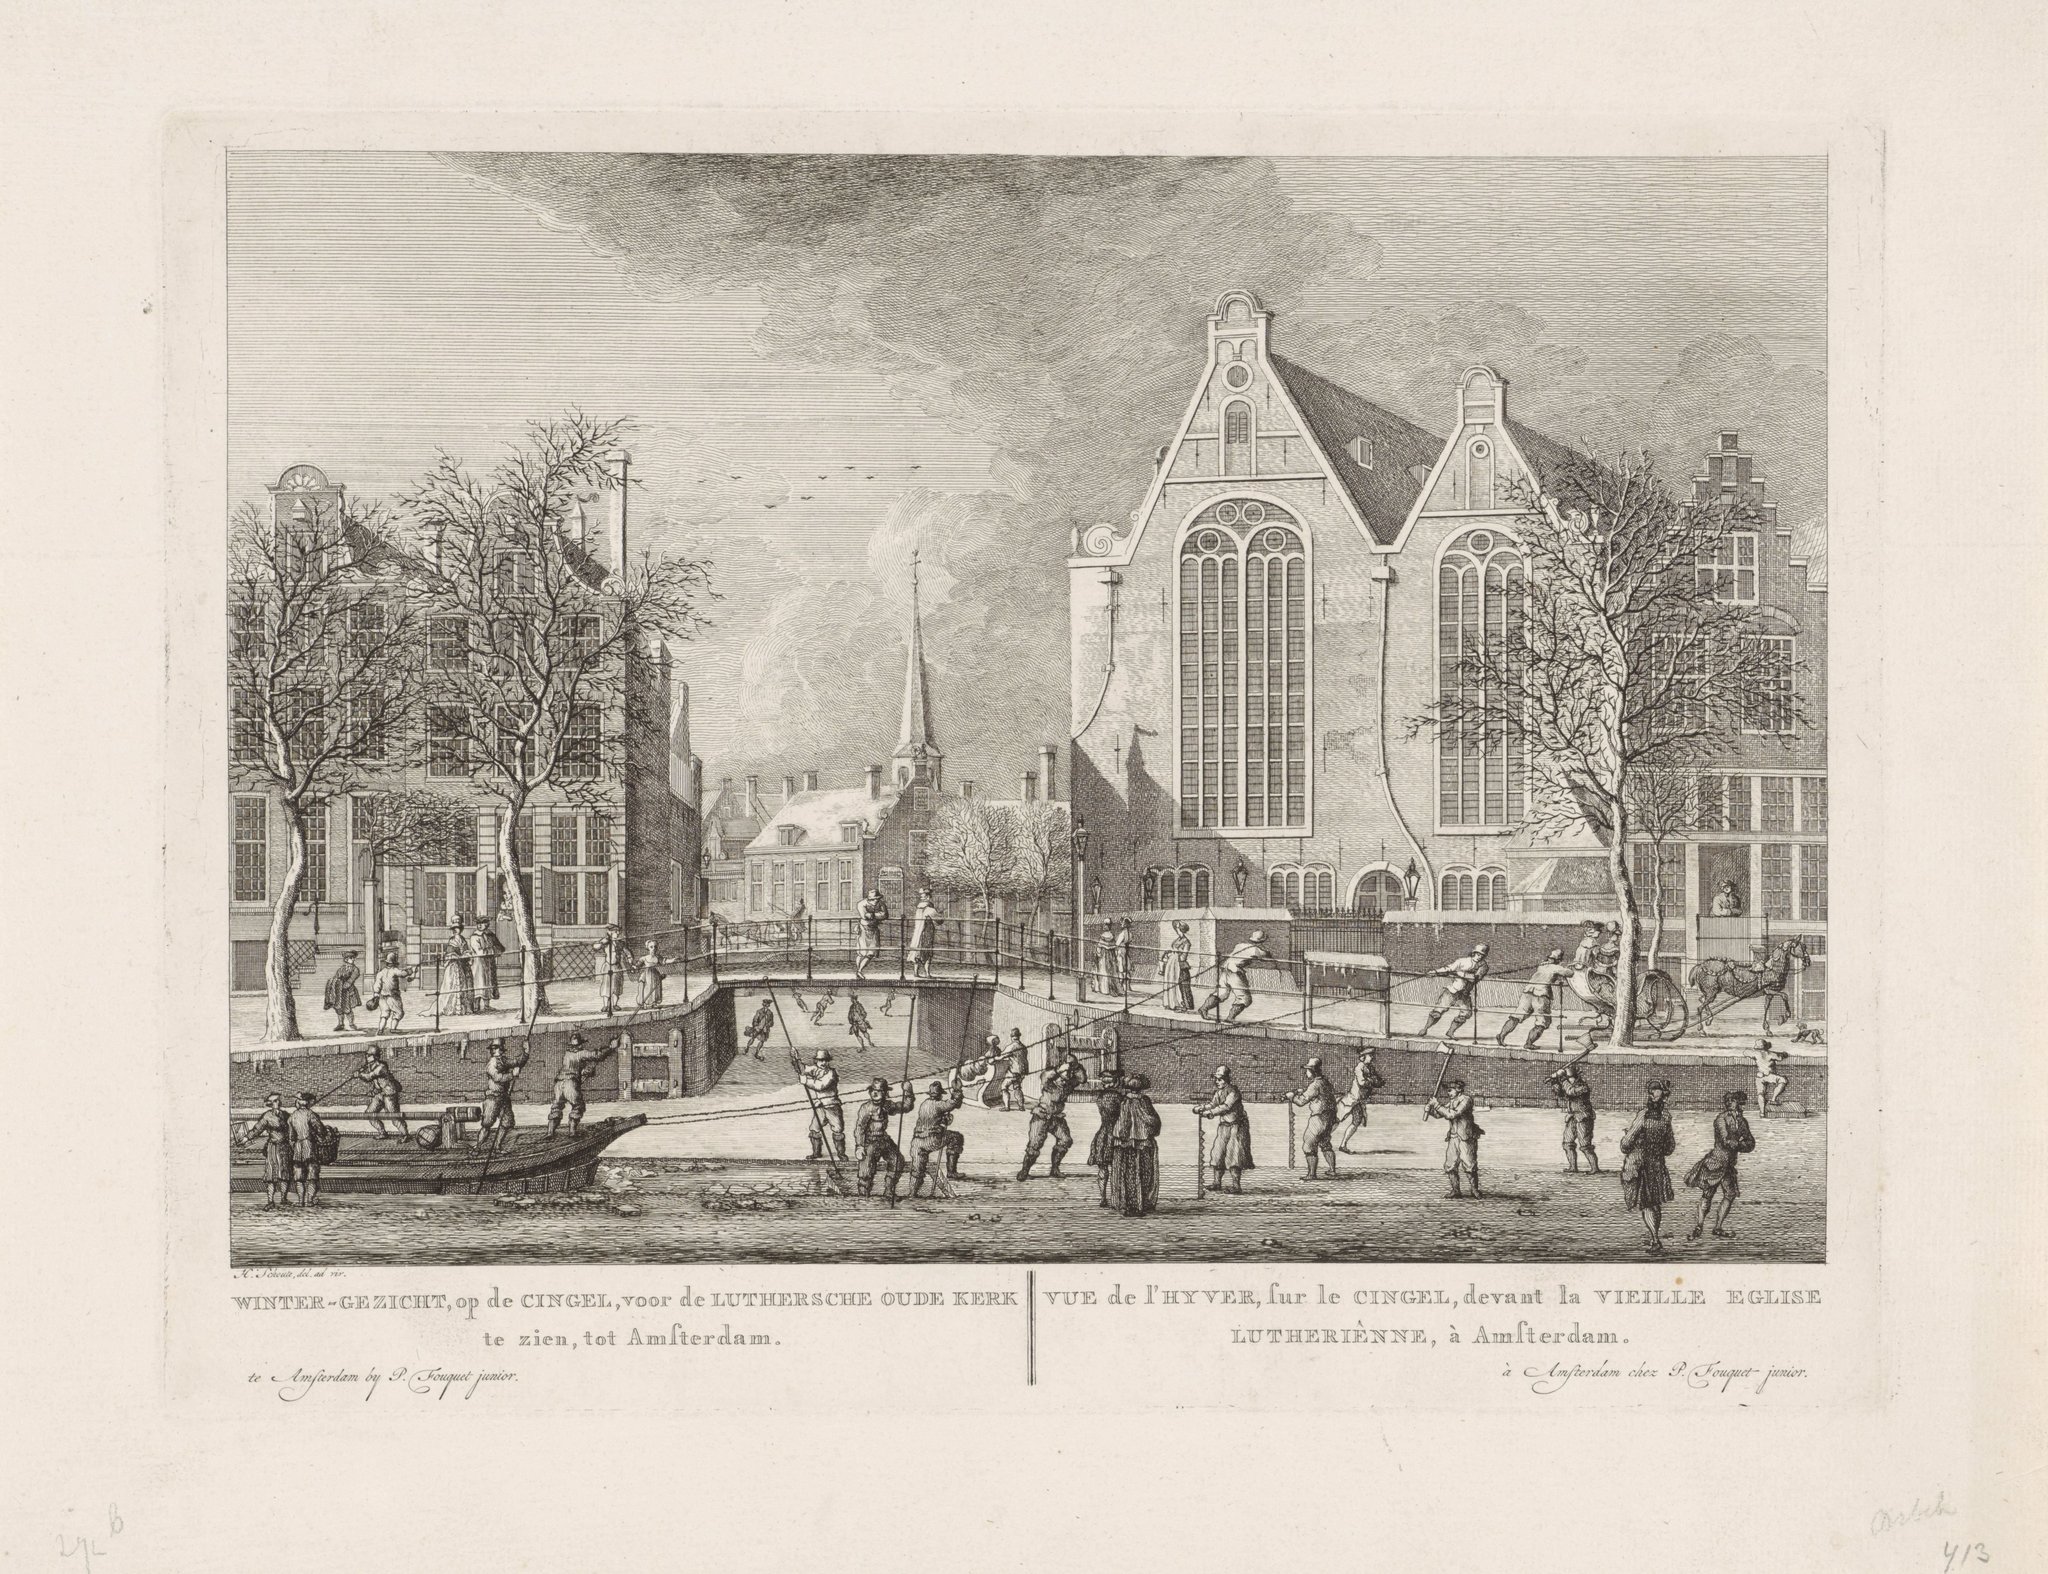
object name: print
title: Winter-Gezicht, op de Cingel, voor de Luthersche Oude Kerk te zien, tot Amsterdam / Vue de l'hyver, sur le Cingel, devant la Vieille Eglise Lutheriênne, à Amsterdam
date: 1770-1783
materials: paper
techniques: engraving, etching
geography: amsterdam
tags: protestant churches and denominations (lutherans), horse-sleigh, winter ~ human activities (the four seasons of the year), church (exterior), skates (winter sports), tow-boat, towing-barge, canals, waters (in city) (+ city(-scape) with figures, staffage), street (+ city(-scape) with figures, staffage)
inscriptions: collector's mark: Lugt 2228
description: Deze prent is ook gebruikt in de zogenaamde Atlas van Fouquet.* Pierre Fouquet gaf vanaf 1760 stadsgezichten van Amsterdam - naar tekeningen van verschillende kunstenaars, gemaakt door verschillende prentmakers - uit. Deze prenten werden aanvankelijk los of in series verkocht. Zoals toen gebruikelijk kon de koper de prenten zelf laten inbinden. Hiertoe gaf Fouquet tussen 1778 en 1783 een titelblad, plattegrond en inhoudsopgave van de tot dusver 100 uitgegeven prenten uit (1). Gezien de inhoud afhankelijk was van wat de koper had verzameld verschilt de inhoud van de verschillende bewaarde Fouquetatlassen onder deze titel sterk. Ook zijn er exemplaren bekend waar tevens andere prenten aan zijn toegevoegd. Omdat er behoefte bleek aan uitleg bij de platen werd in 1783 een nieuwe versie van de atlas uitgegeven, aangevuld met tekst en twee prenten. De aangegeven volgorde veranderde maar de platen van de al eerder uitgegeven prenten bleven ongewijzigd. Deze uitgave werd in opdracht van Fouquet gedrukt bij Daniël Jean Changuion en Petrus den Hengst (2). Een tiental platen werd bijgewerkt en verscheen, met nieuw impressum, in het vervolg van Wagenaars geschiedenis van Amsterdam, uitgeven door Petrus Conradi en Folkert van der Plaats (3). Een aantal jaar na het overlijden van Fouquet kwam Evert Maaskamp met een nieuwe uitgave van de atlas, met verbeterde tekst en toevoeging van twee prenten. Op alle platen verwijderde hij het oude en liet hij zijn eigen impressum zetten (4). De huidige staat van de prent komt voor in exemplaren van de onder (1) en (2) genoemde werken. * Onder de Atlas van Fouquet of Fouquetatlas verstaan we de hieronder vermelde publicaties (1), (2) en (4). (1). Afbeeldingen van de wyd-vermaarde koopstad Amsterdam benevens des zelvs voornaamste gebouwen en gezigten alle naar het leeven getekend / Receuil des edifices les plus considerables et des plus belles vues, de la fameuse ville d'Amsterdam, dessinées d'après nature. Amsterdam: Pierre Fouquet, 1778-1783. (2). Nieuwe atlas, van de voornaamste gebouwen en gezigten der stad Amsterdam, met derzelver beknopte beschryvingen. 2 delen. Amsterdam: Daniël Jean Changuion en Petrus den Hengst [in opdracht van Pierre Fouquet], 1783. (3). Stijl, Simon. Amsterdam, in zyne geschiedenissen, voorregten, koophandel, gebouwen, kerkenstaat, schoolen, schutterye, gilden en regeeringe, beschreeven. Om te dienen ten vervolge op het werk van Jan Wagenaar (…). 10 delen. Amsterdam en Harlingen: Petrus Conradi en Folkert van der Plaats, 1788-1801. (4). Nieuwe atlas, van de voornaamste gebouwen en gezigten der stad Amsterdam. Met derzelver beknopte beschryvingen. Amsterdam: Evert Maaskamp, 1805. * Het aantal vermelde staten is gebaseerd op het aantal gevonden staten. Mogelijk zijn er meer staten van deze prent. Zie RP-P-AO-24-1AX voor latere staat.